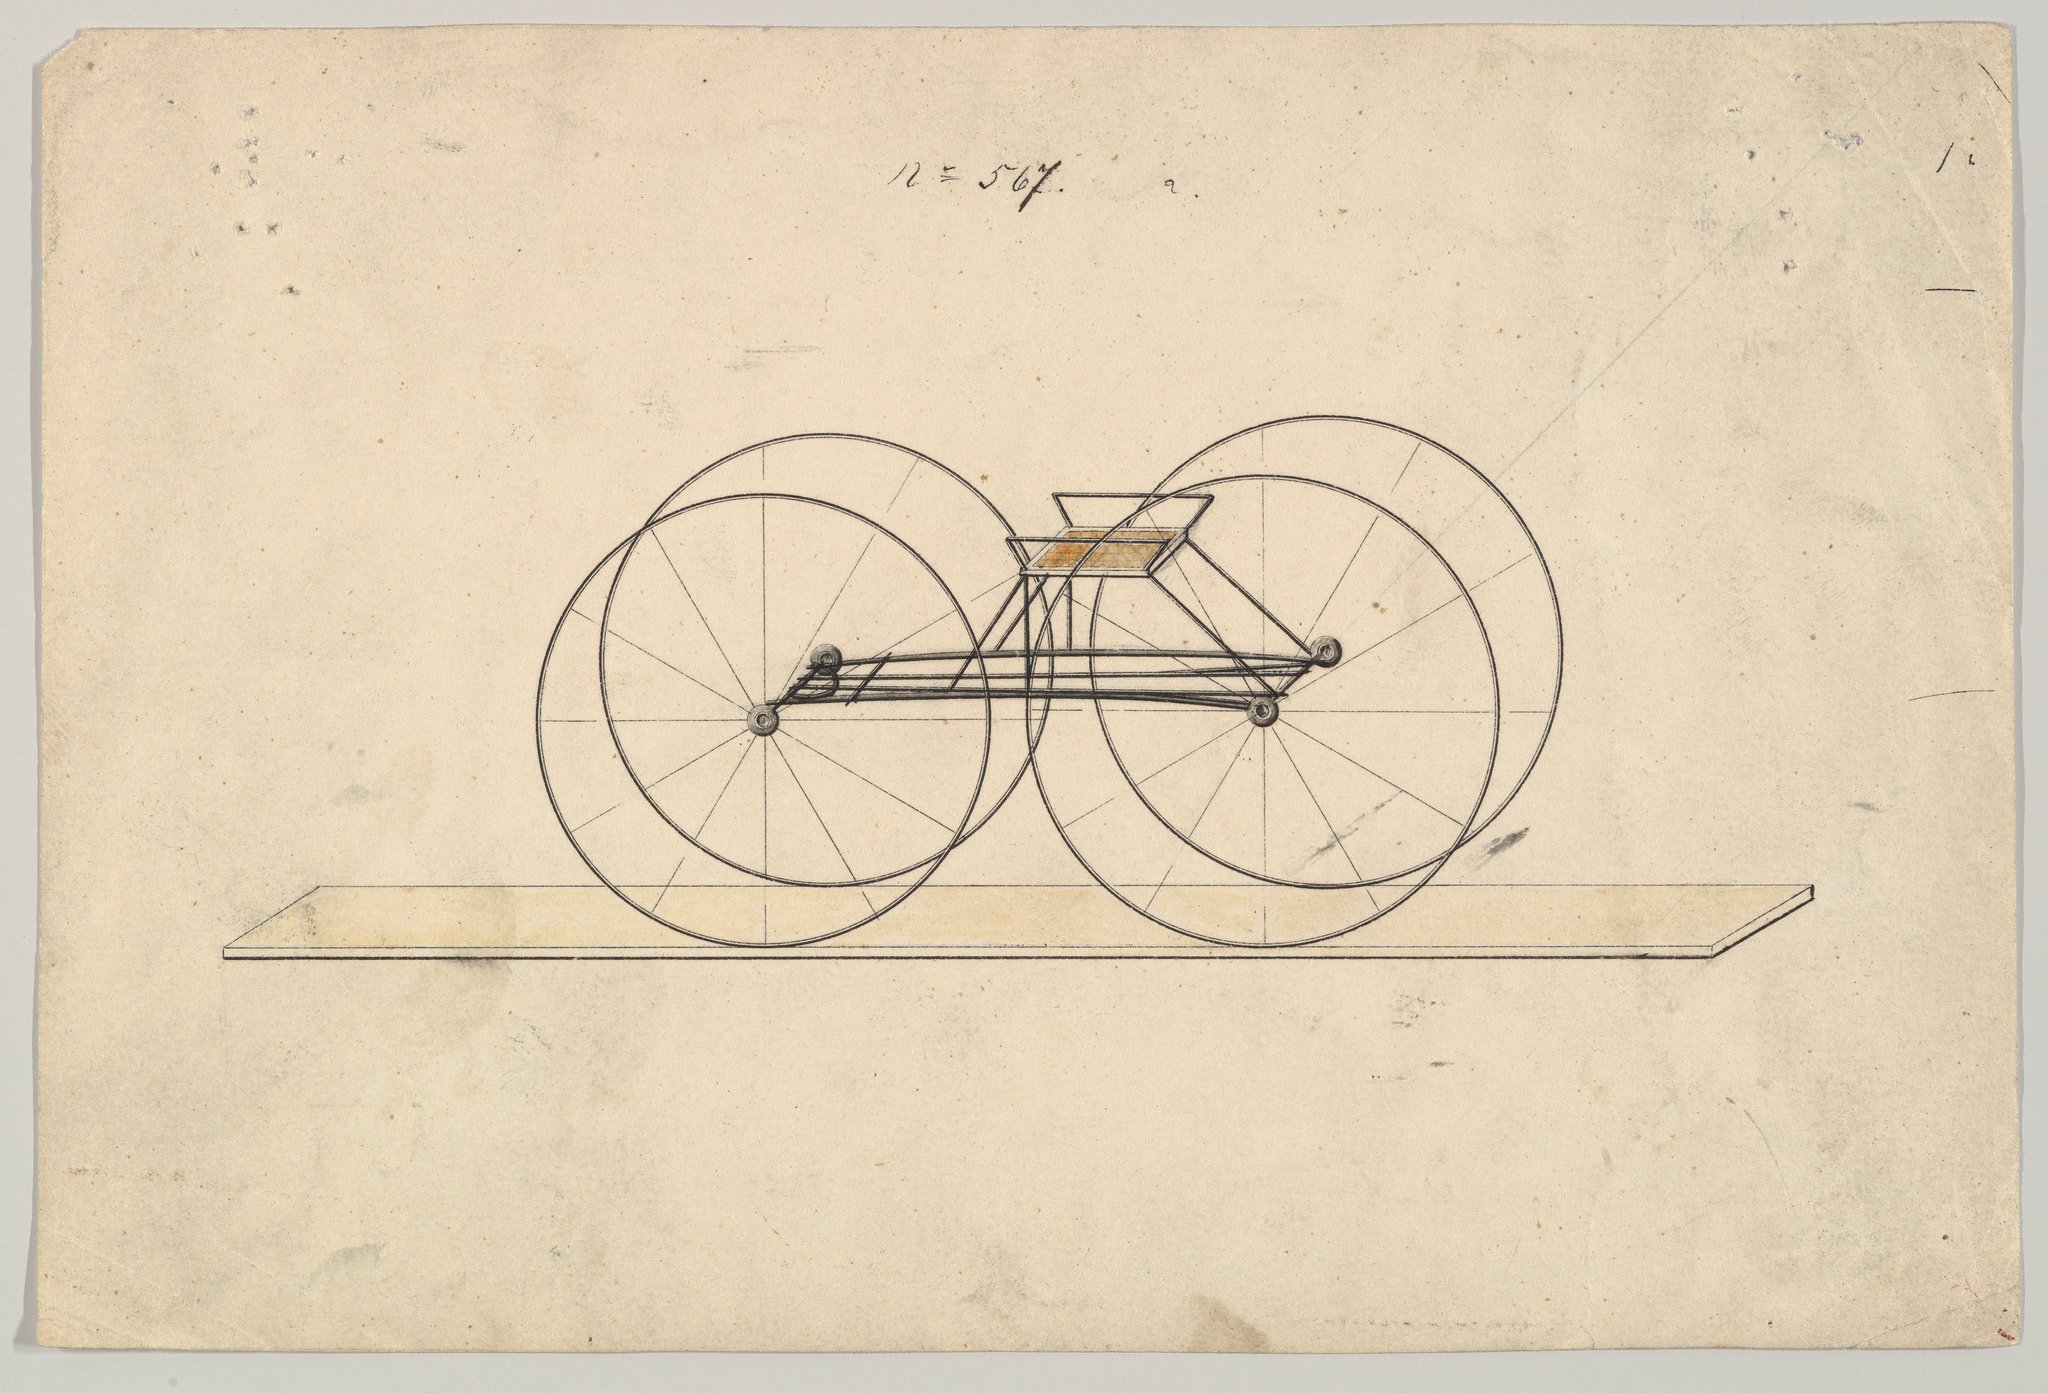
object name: drawing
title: Skeleton Wagon #567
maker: brewster & co.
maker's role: manufacturer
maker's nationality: american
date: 1865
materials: ink, watercolor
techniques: pen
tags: carriages